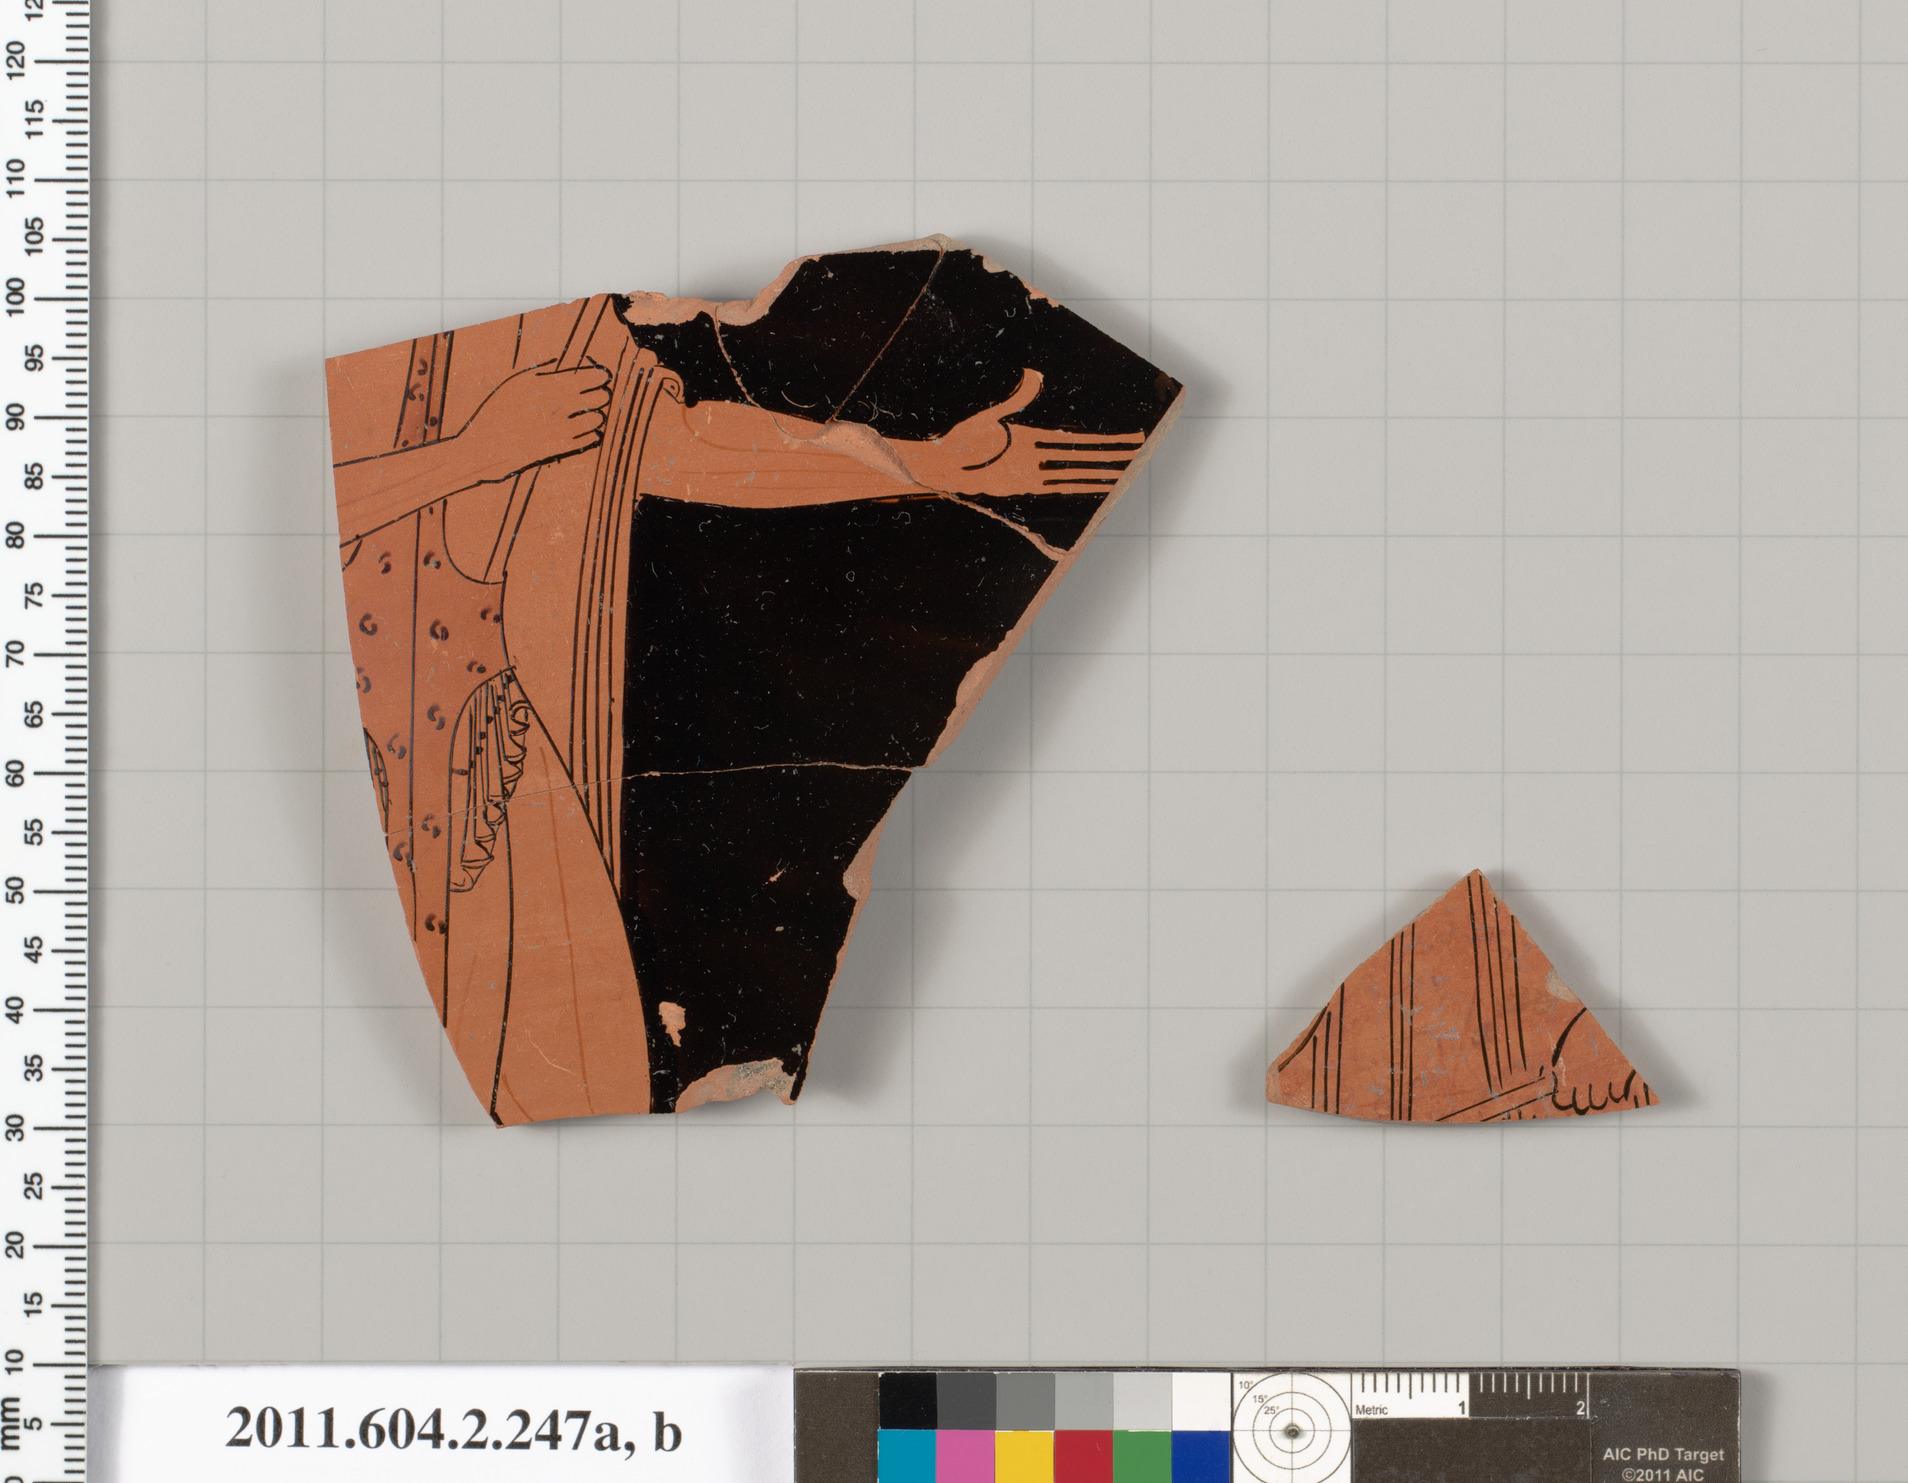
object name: stamnos fragment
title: Terracotta fragments of a stamnos (jar)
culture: greek, attic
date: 520-510 BCE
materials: terracotta